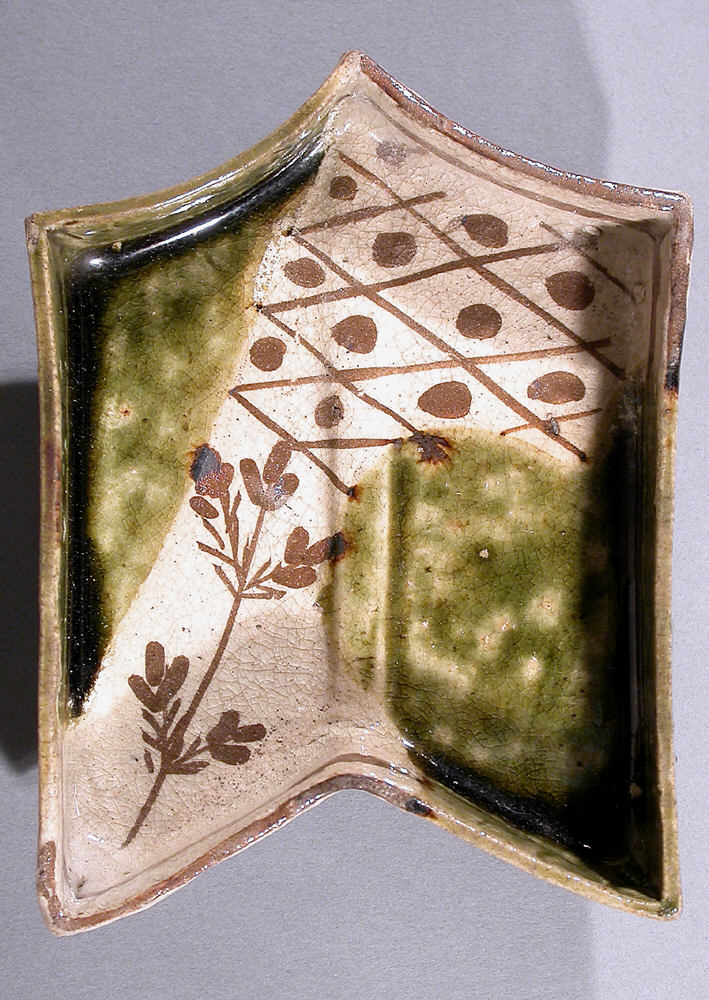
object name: dish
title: Dish in the Shape of an Arrow's Fletching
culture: japanese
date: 1601-1633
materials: copper, glaze, iron, stoneware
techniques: underglaze